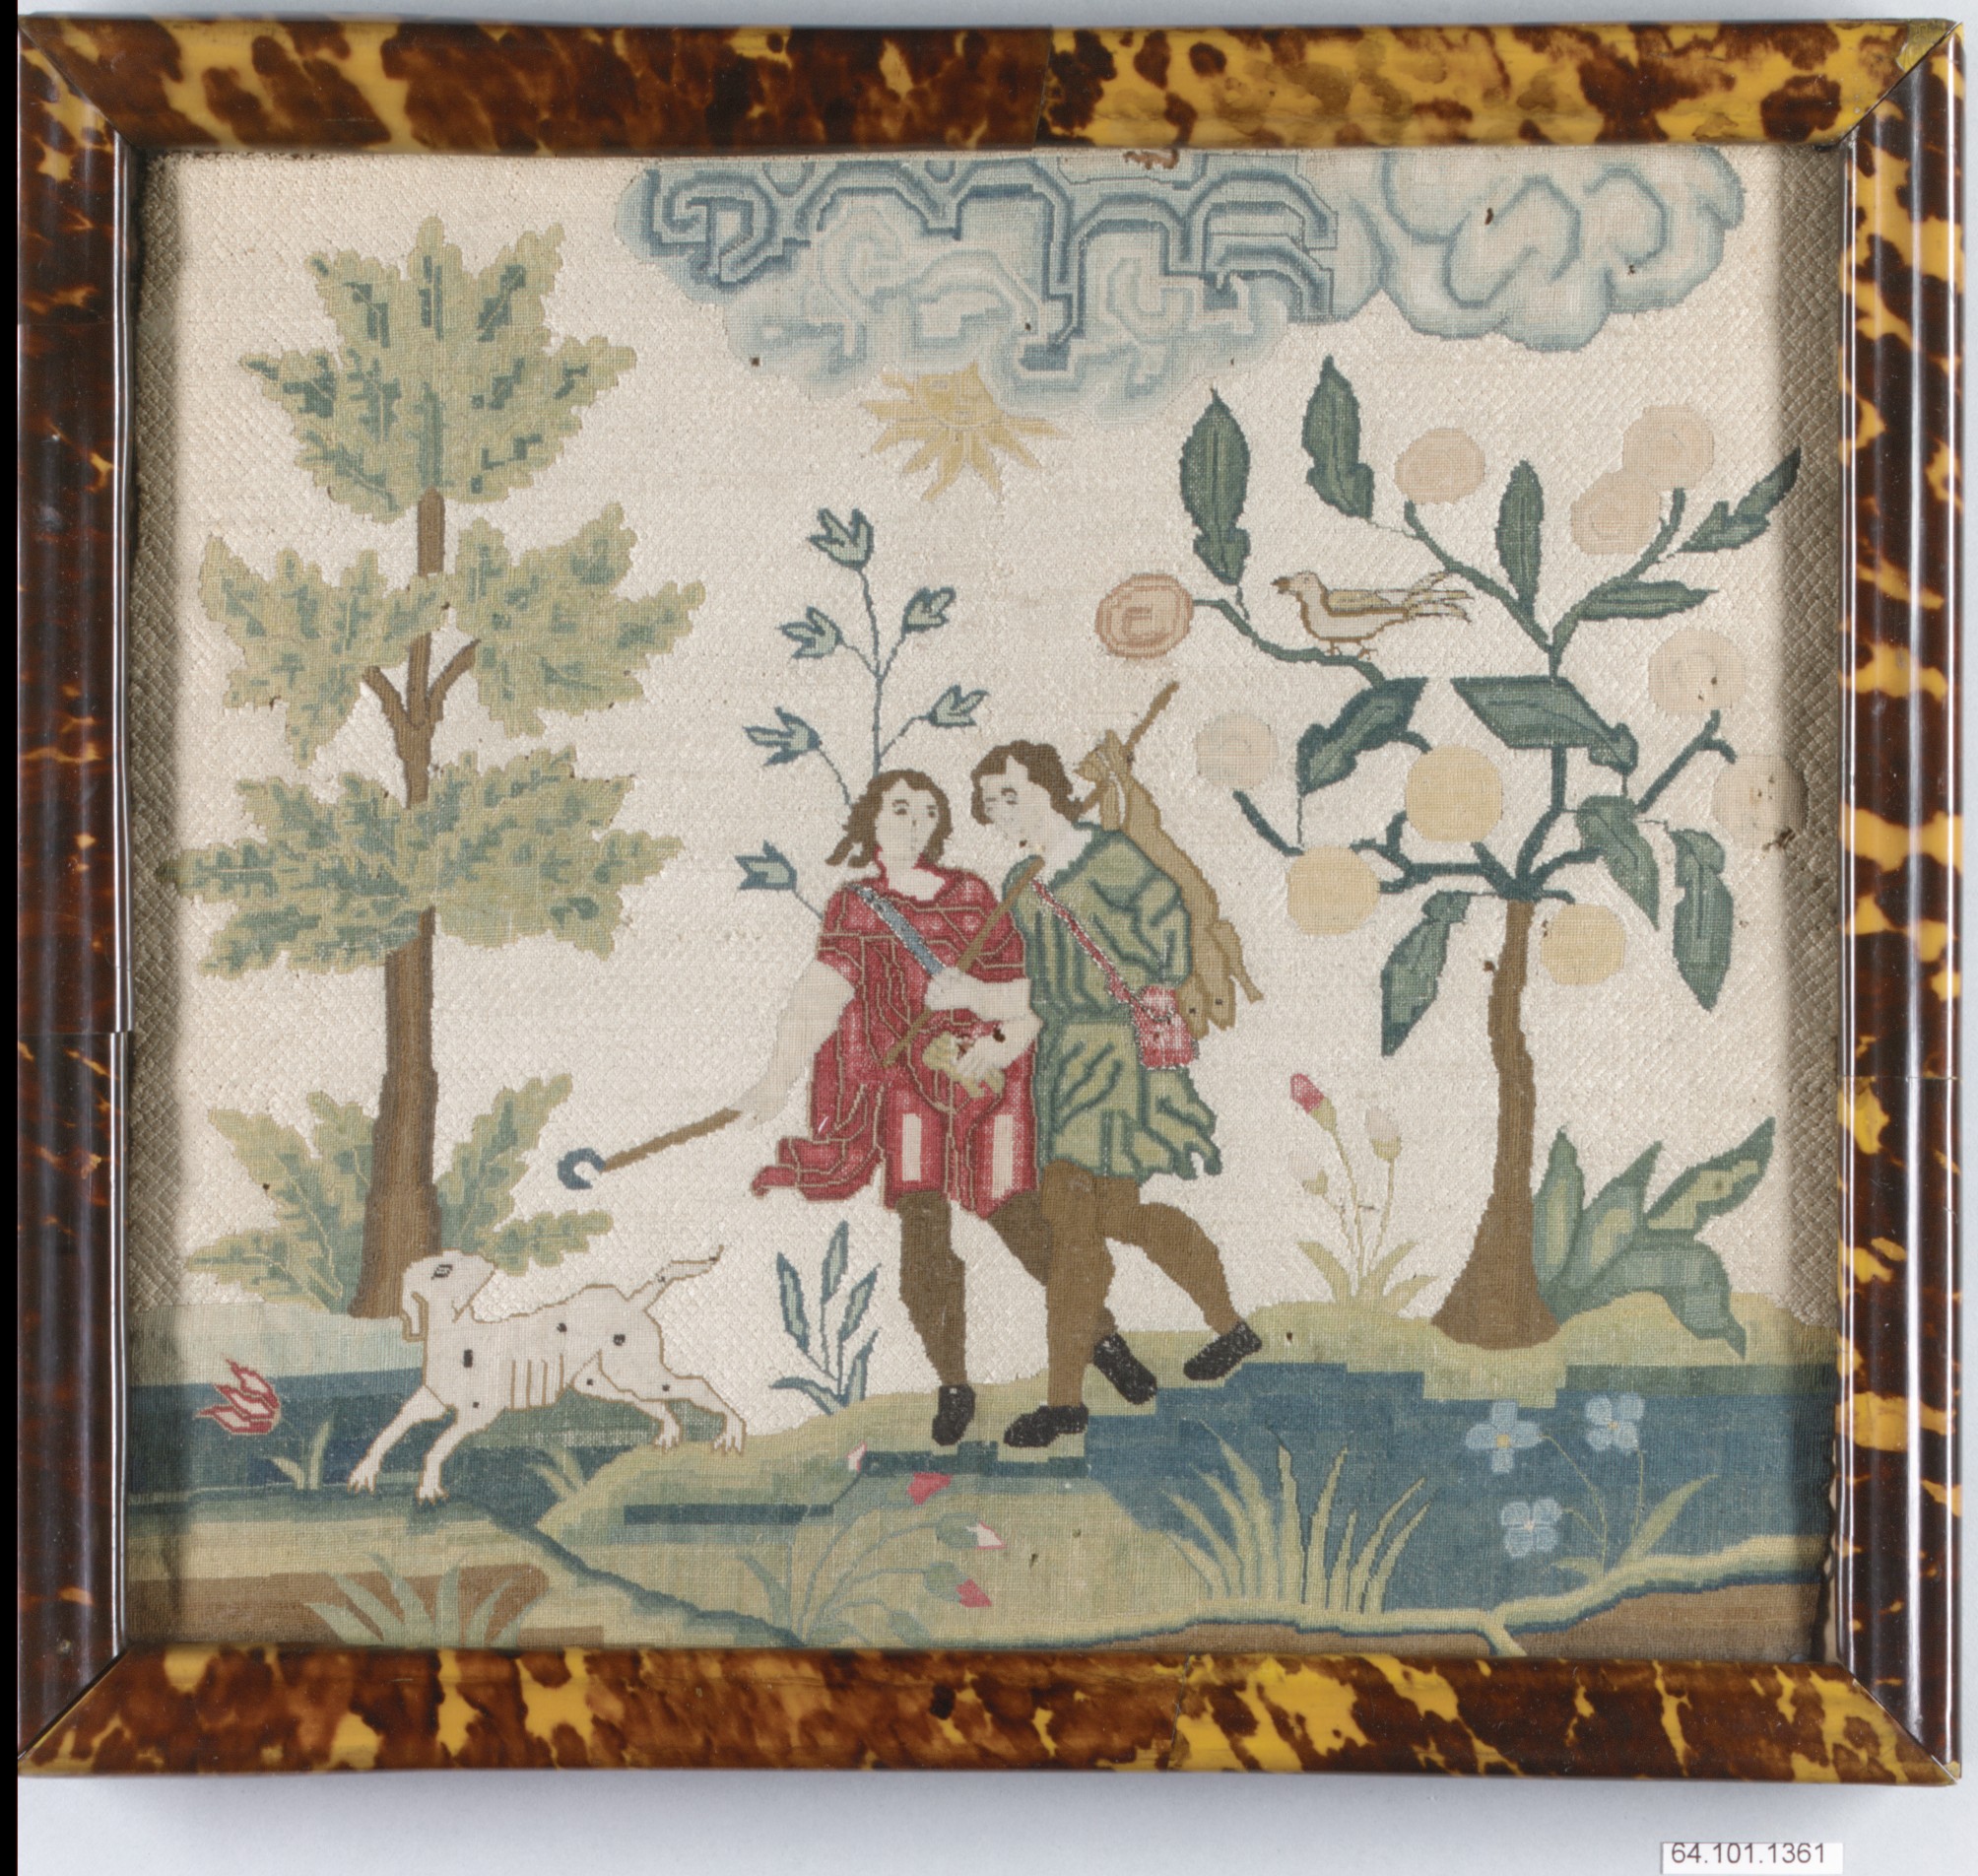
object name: embroidered picture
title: Embroidered picture with hunting scene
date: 1701-1725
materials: canvas, metal thread, silk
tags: birds,men,hunting,dogs